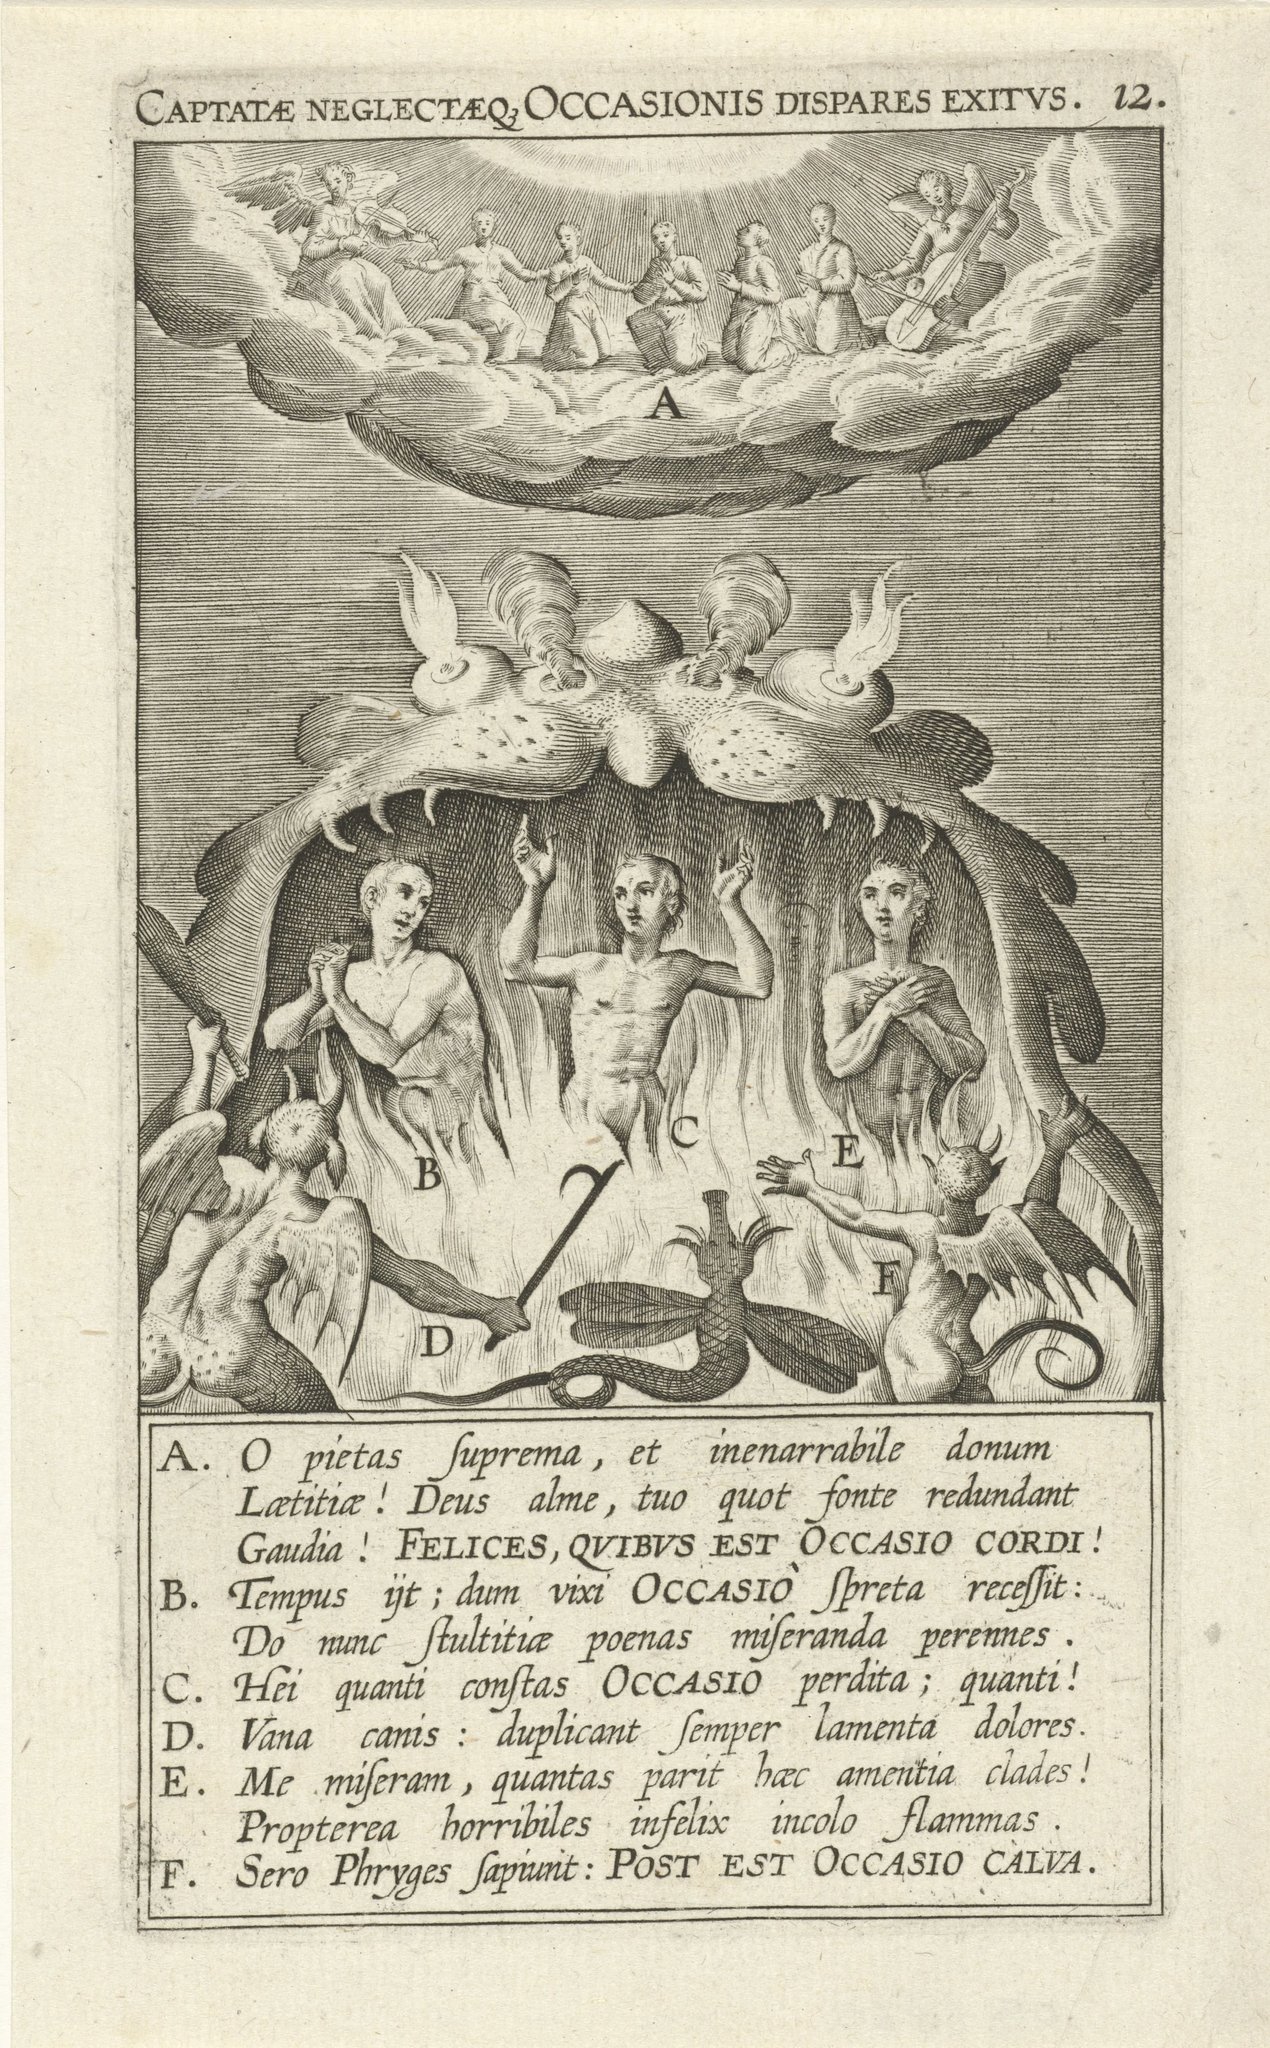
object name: print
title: Typus occasionis in quo receptae commoda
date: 1603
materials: paper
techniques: engraving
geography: antwerp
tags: angels singing, making music, youth, adolescent, representations of hell (with the damned and devils), usually with burning fires, entrance of hell as monstrous mouth (of leviathan), man as sinner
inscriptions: collector's mark: Lugt 2228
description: Drie zondige jongeren zitten in de hellemond en worden met vuur gemarteld door duivels. Centraal boven de vijf deugdzame jongeren in de hemel, begeleid door engelenmuziek. De prent heeft een Latijns onderschrift met legende en maakt deel uit van een 12-delige serie over het benutten van kansen.